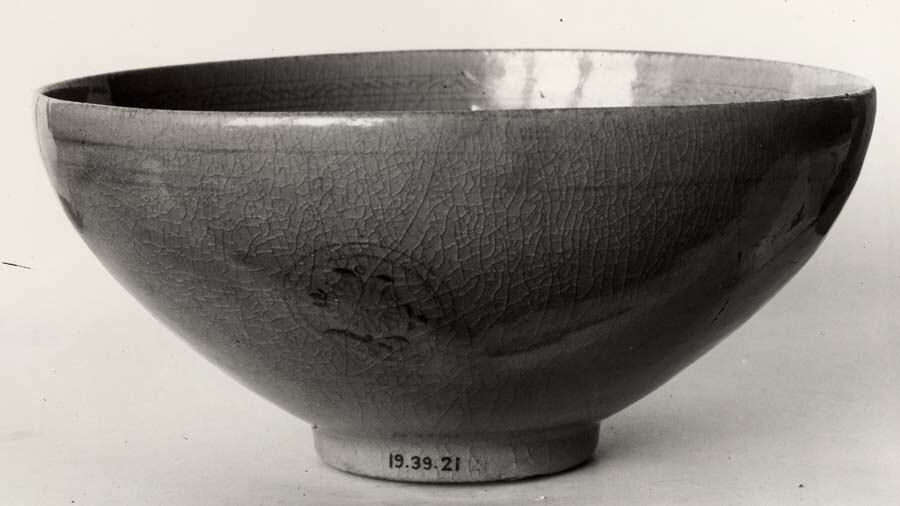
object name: bowl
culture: korean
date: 918-1392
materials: clay